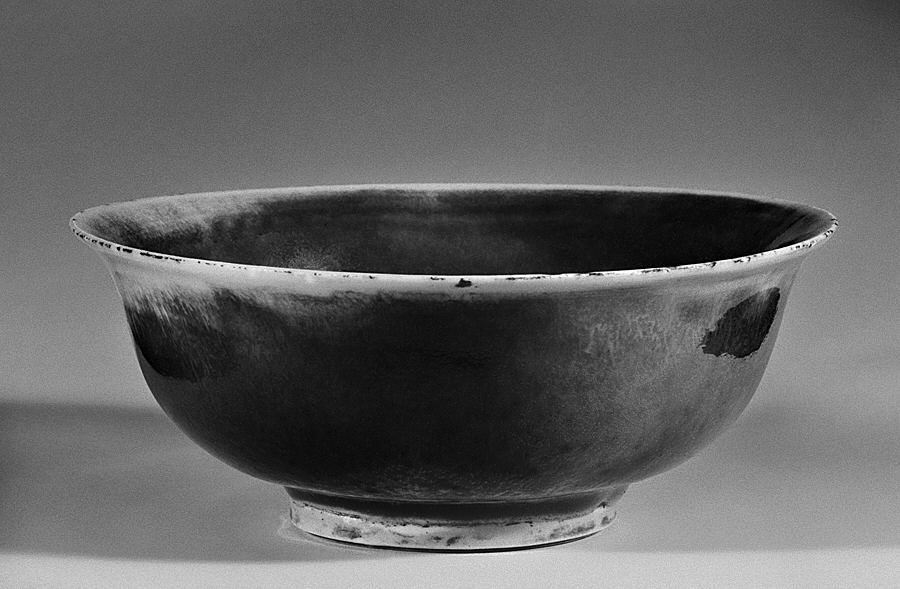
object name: bowl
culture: chinese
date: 1801-1900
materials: glaze, porcelain